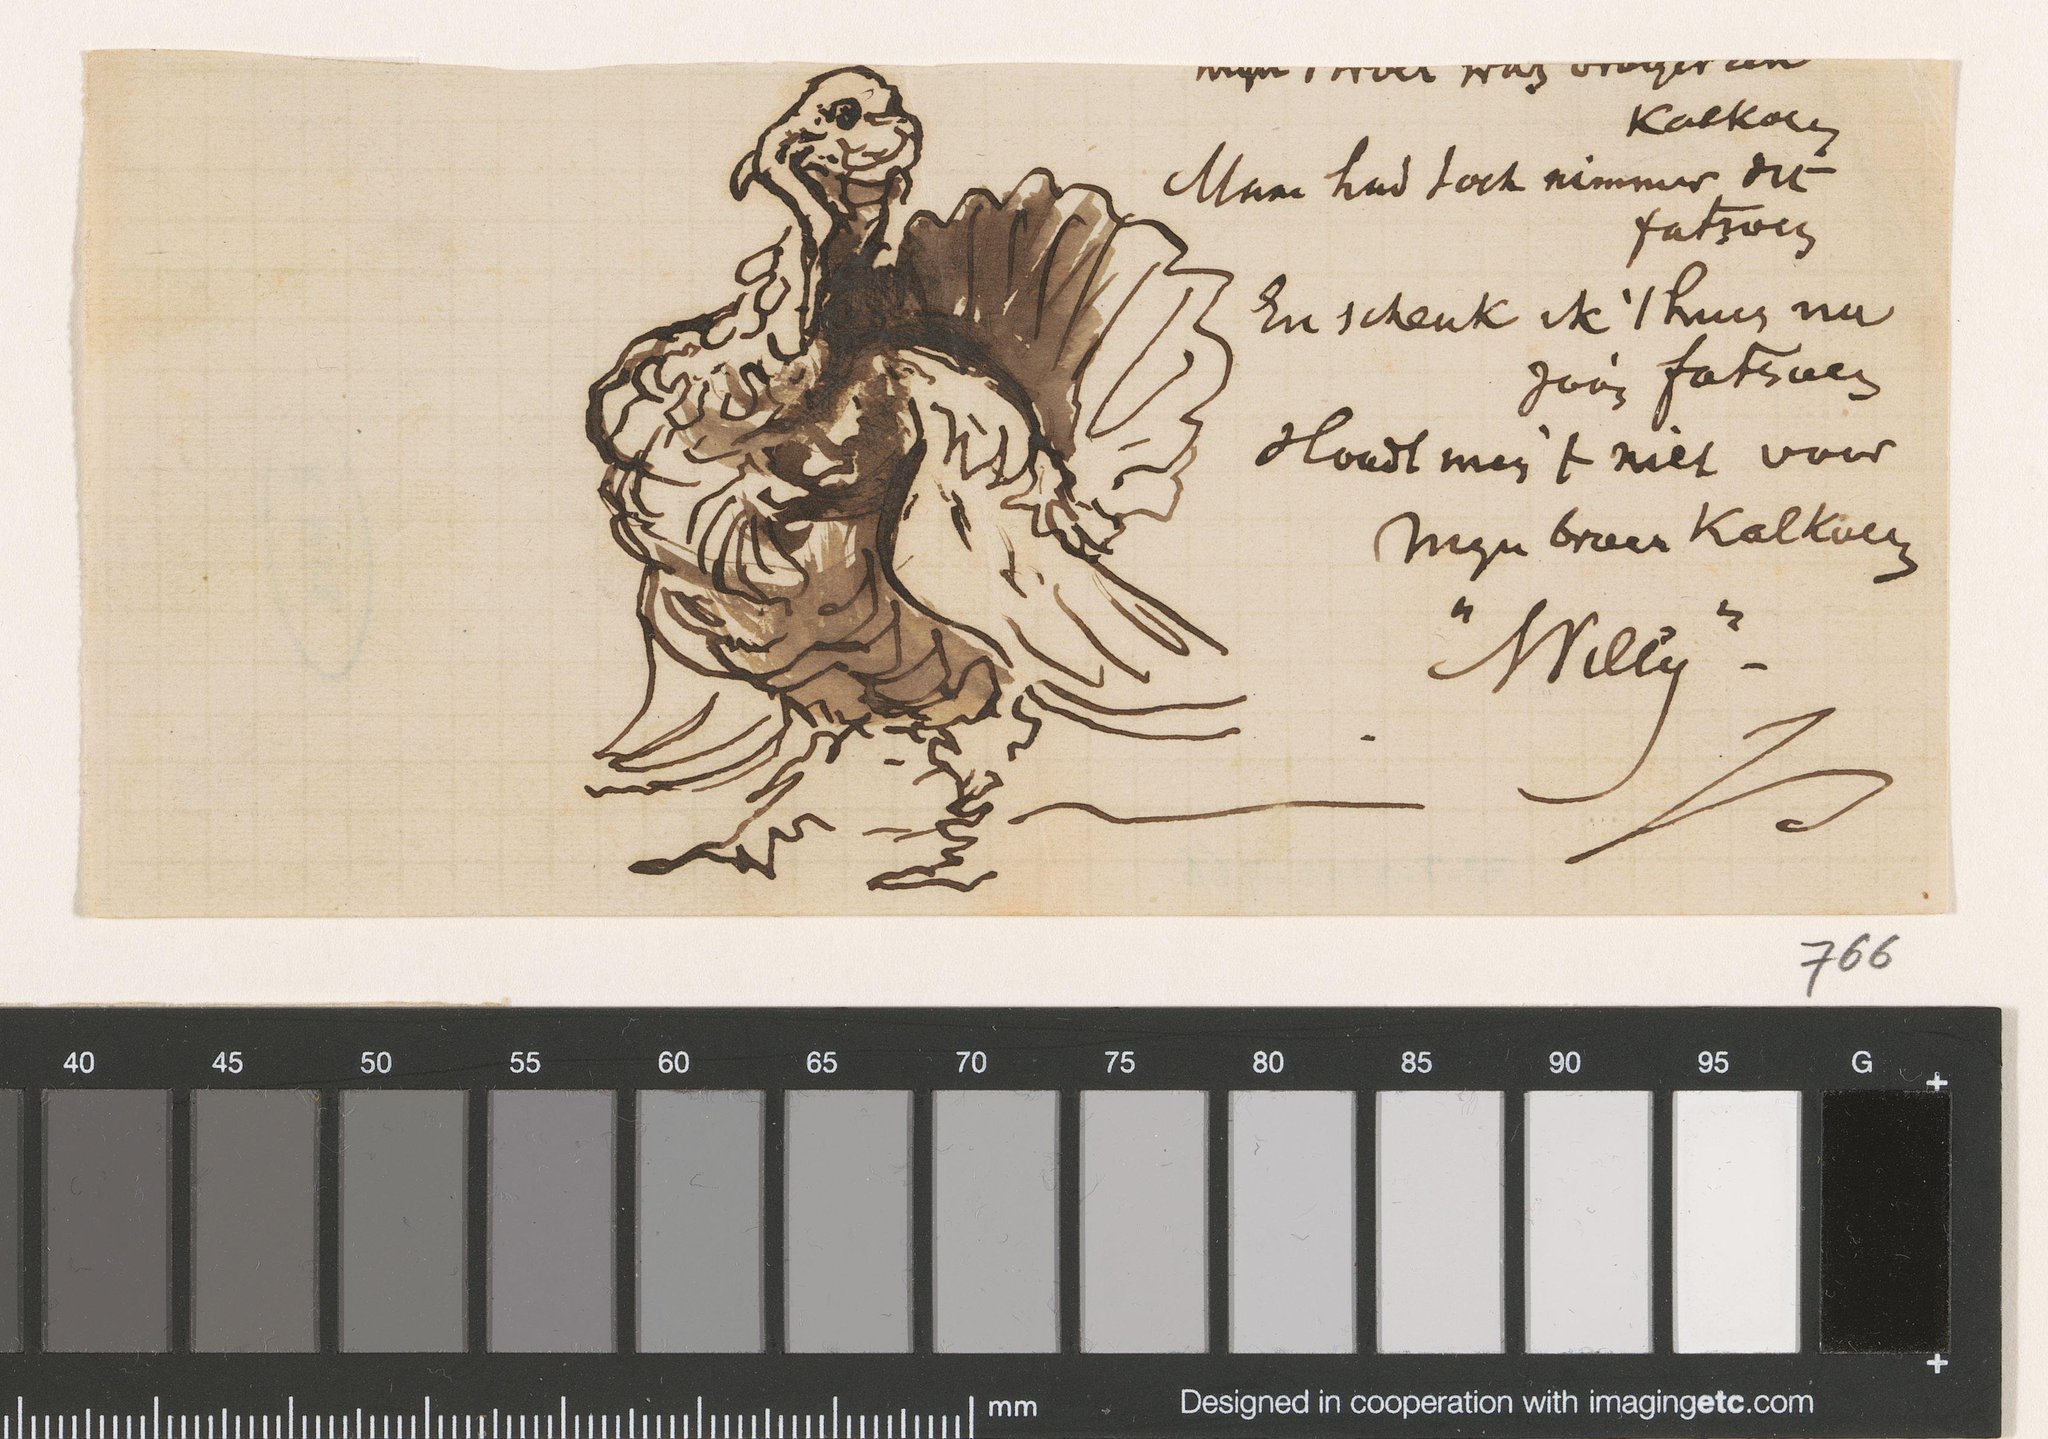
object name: drawing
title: Kalkoen, met versje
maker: johannes tavenraat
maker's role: draughtsman, painter, print maker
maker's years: 1809-1881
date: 1840-1880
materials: ink, paper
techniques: brush, pen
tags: walker and runner birds: turkey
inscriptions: annotation: ‘Maar had toch nimmer het fatsoen ... mijn broer kalkoen "Willy"’, collector's mark: Lugt 2228